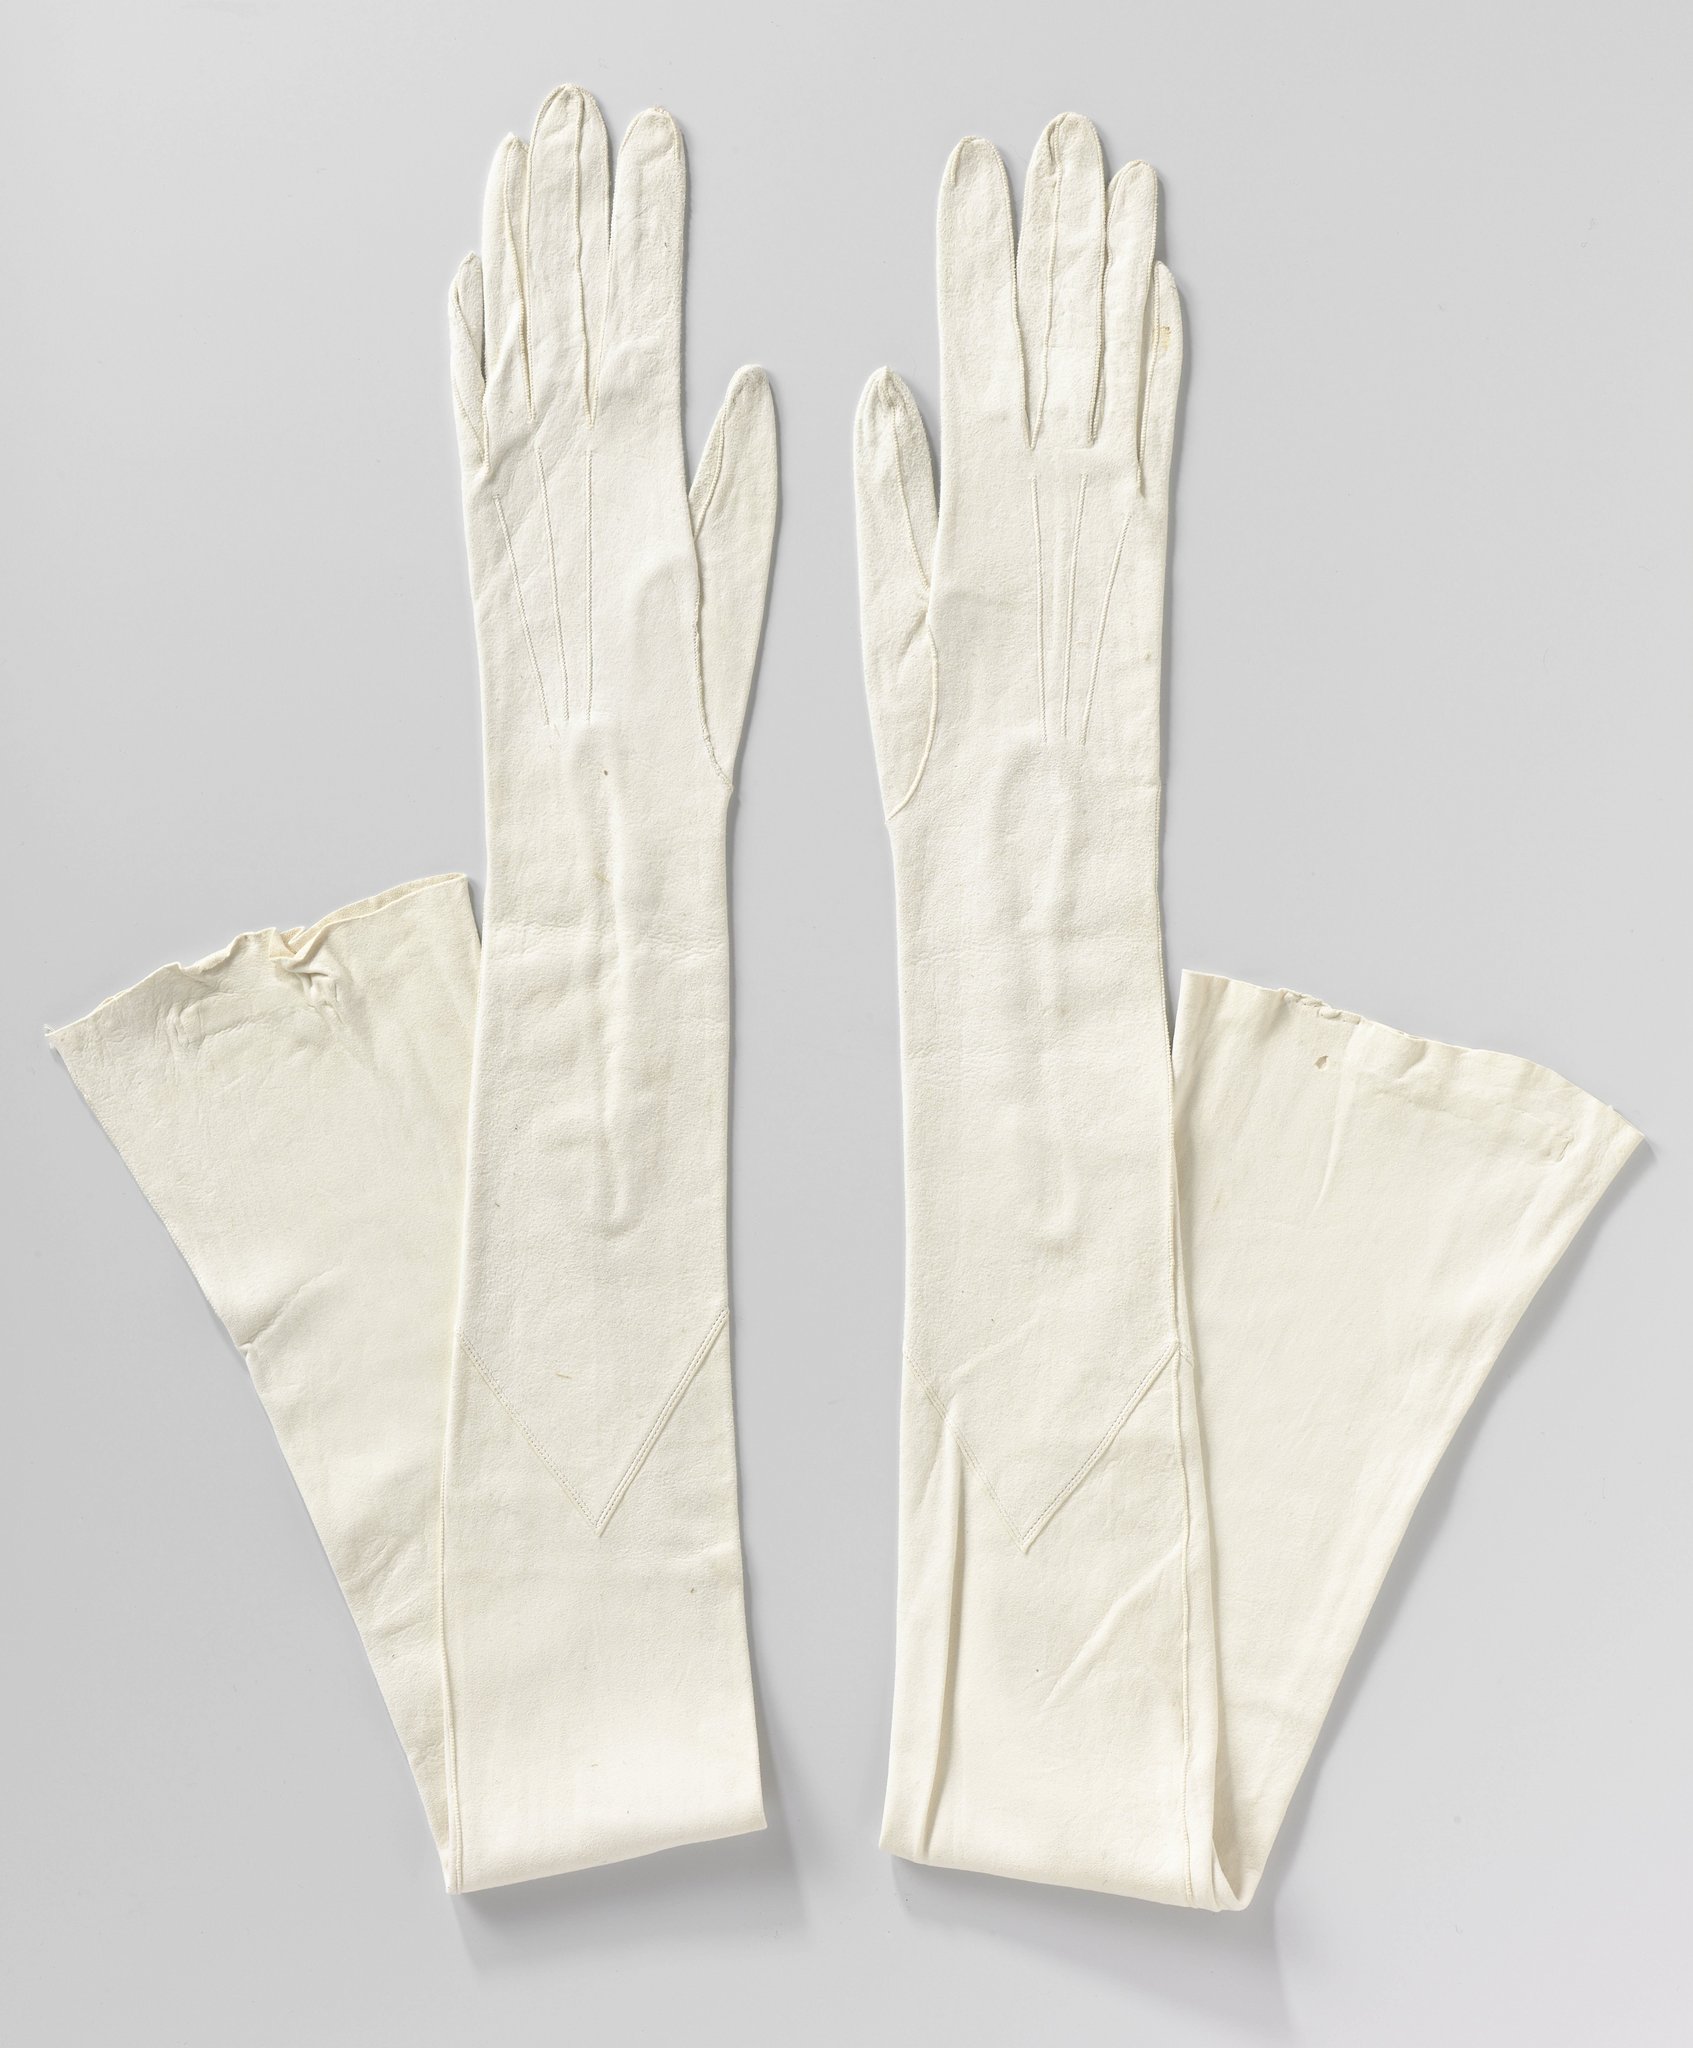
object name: glove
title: Handschoen, galahandschoen, van wit wasleer met sluiting van parelmoeren knoopjes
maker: m. laimböck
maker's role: modehuis, modewarenhuis, modewinkel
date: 1930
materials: leather, mother of pearl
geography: amsterdam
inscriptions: address: ‘Gants Lavable/ Laimböck/ Tyrol, Amsterdam/ K. Hofleverancier’, name: ‘M. Laimböck’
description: Rechter handschoenen van wit wasleer, met sluiting van vier parelmoeren knoopjes. Nauwsluitend model, tot over de gehele bovenarm. Onder de elleboog een puntig sierstiksel. Adres: Gant Lavable/ Laimböck/ Tyrol, Amsterdam / K. Hofleverancier / 6 3/4.